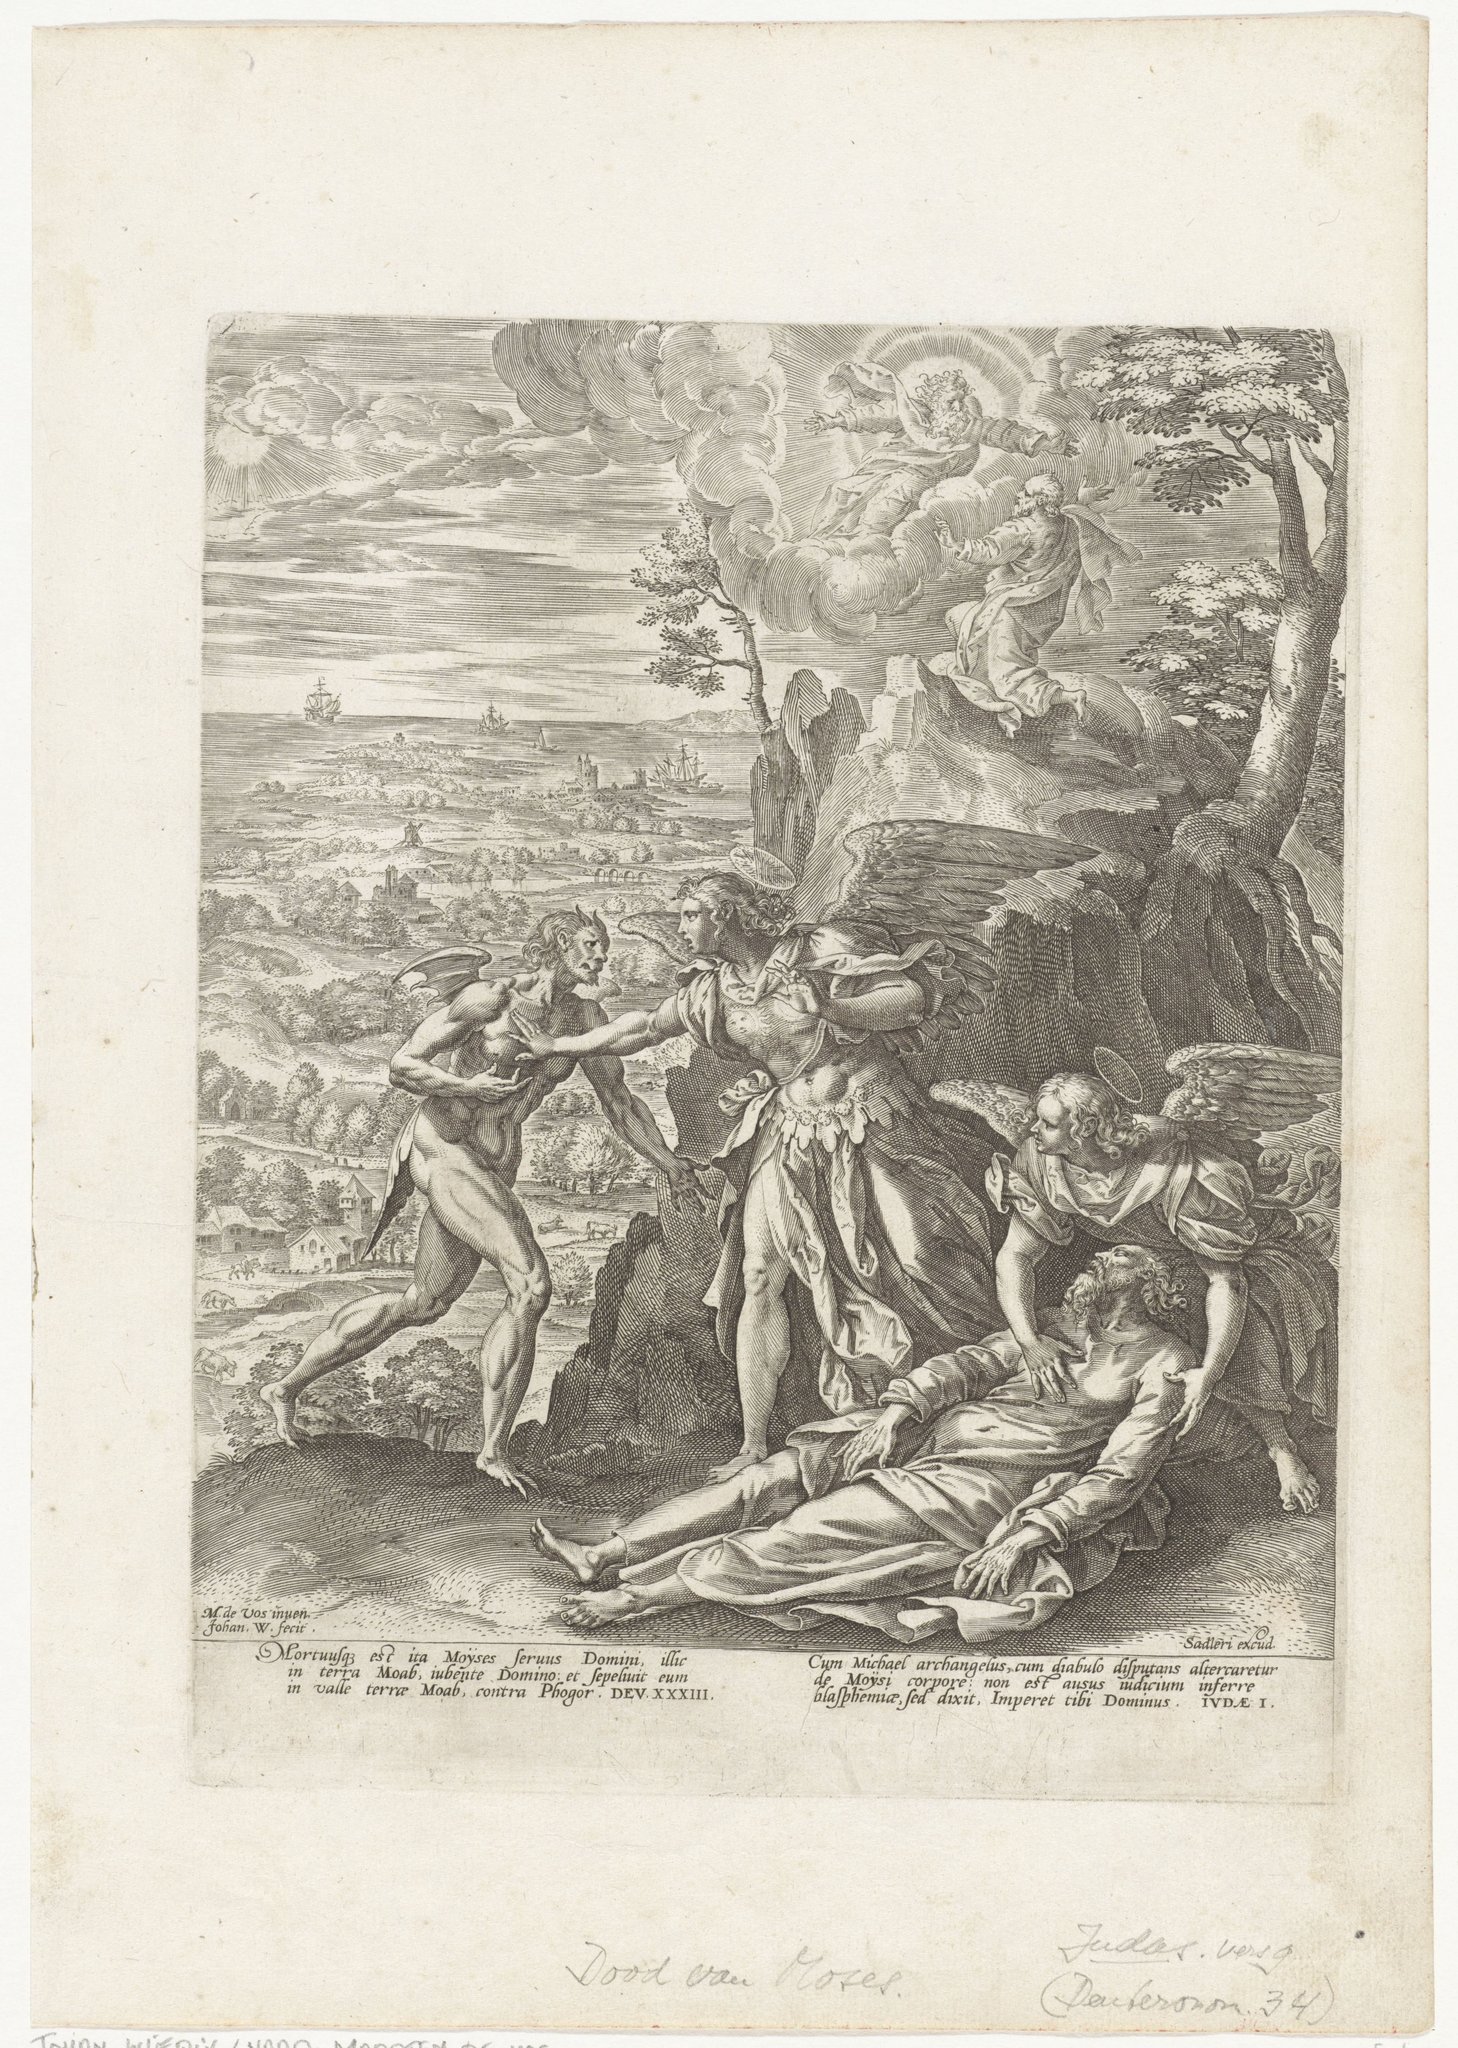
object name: print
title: Dood van Mozes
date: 1582-1583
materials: paper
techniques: engraving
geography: antwerp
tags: the contest of st. michael and satan for the body of moses on mount nebo (jude 9)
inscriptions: collector's mark: Lugt 2228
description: Mozes sterft op de top Nebo van de berg Pisga nadat God hem het land heeft laten zien dat hij aan Abraham, Isaak en Jakob zal geven. Aartsengel Michaël weert de duivel af, die met hem twist om het lichaam van Mozes, dat op de vlakte van Moab begraven zal worden. Op de top van de berg wordt Mozes door God in de hemel ontvangen. In de marge twee Bijbelcitaten uit Deut. 34 en uit Judas, in twee kolommen, in het Latijn.